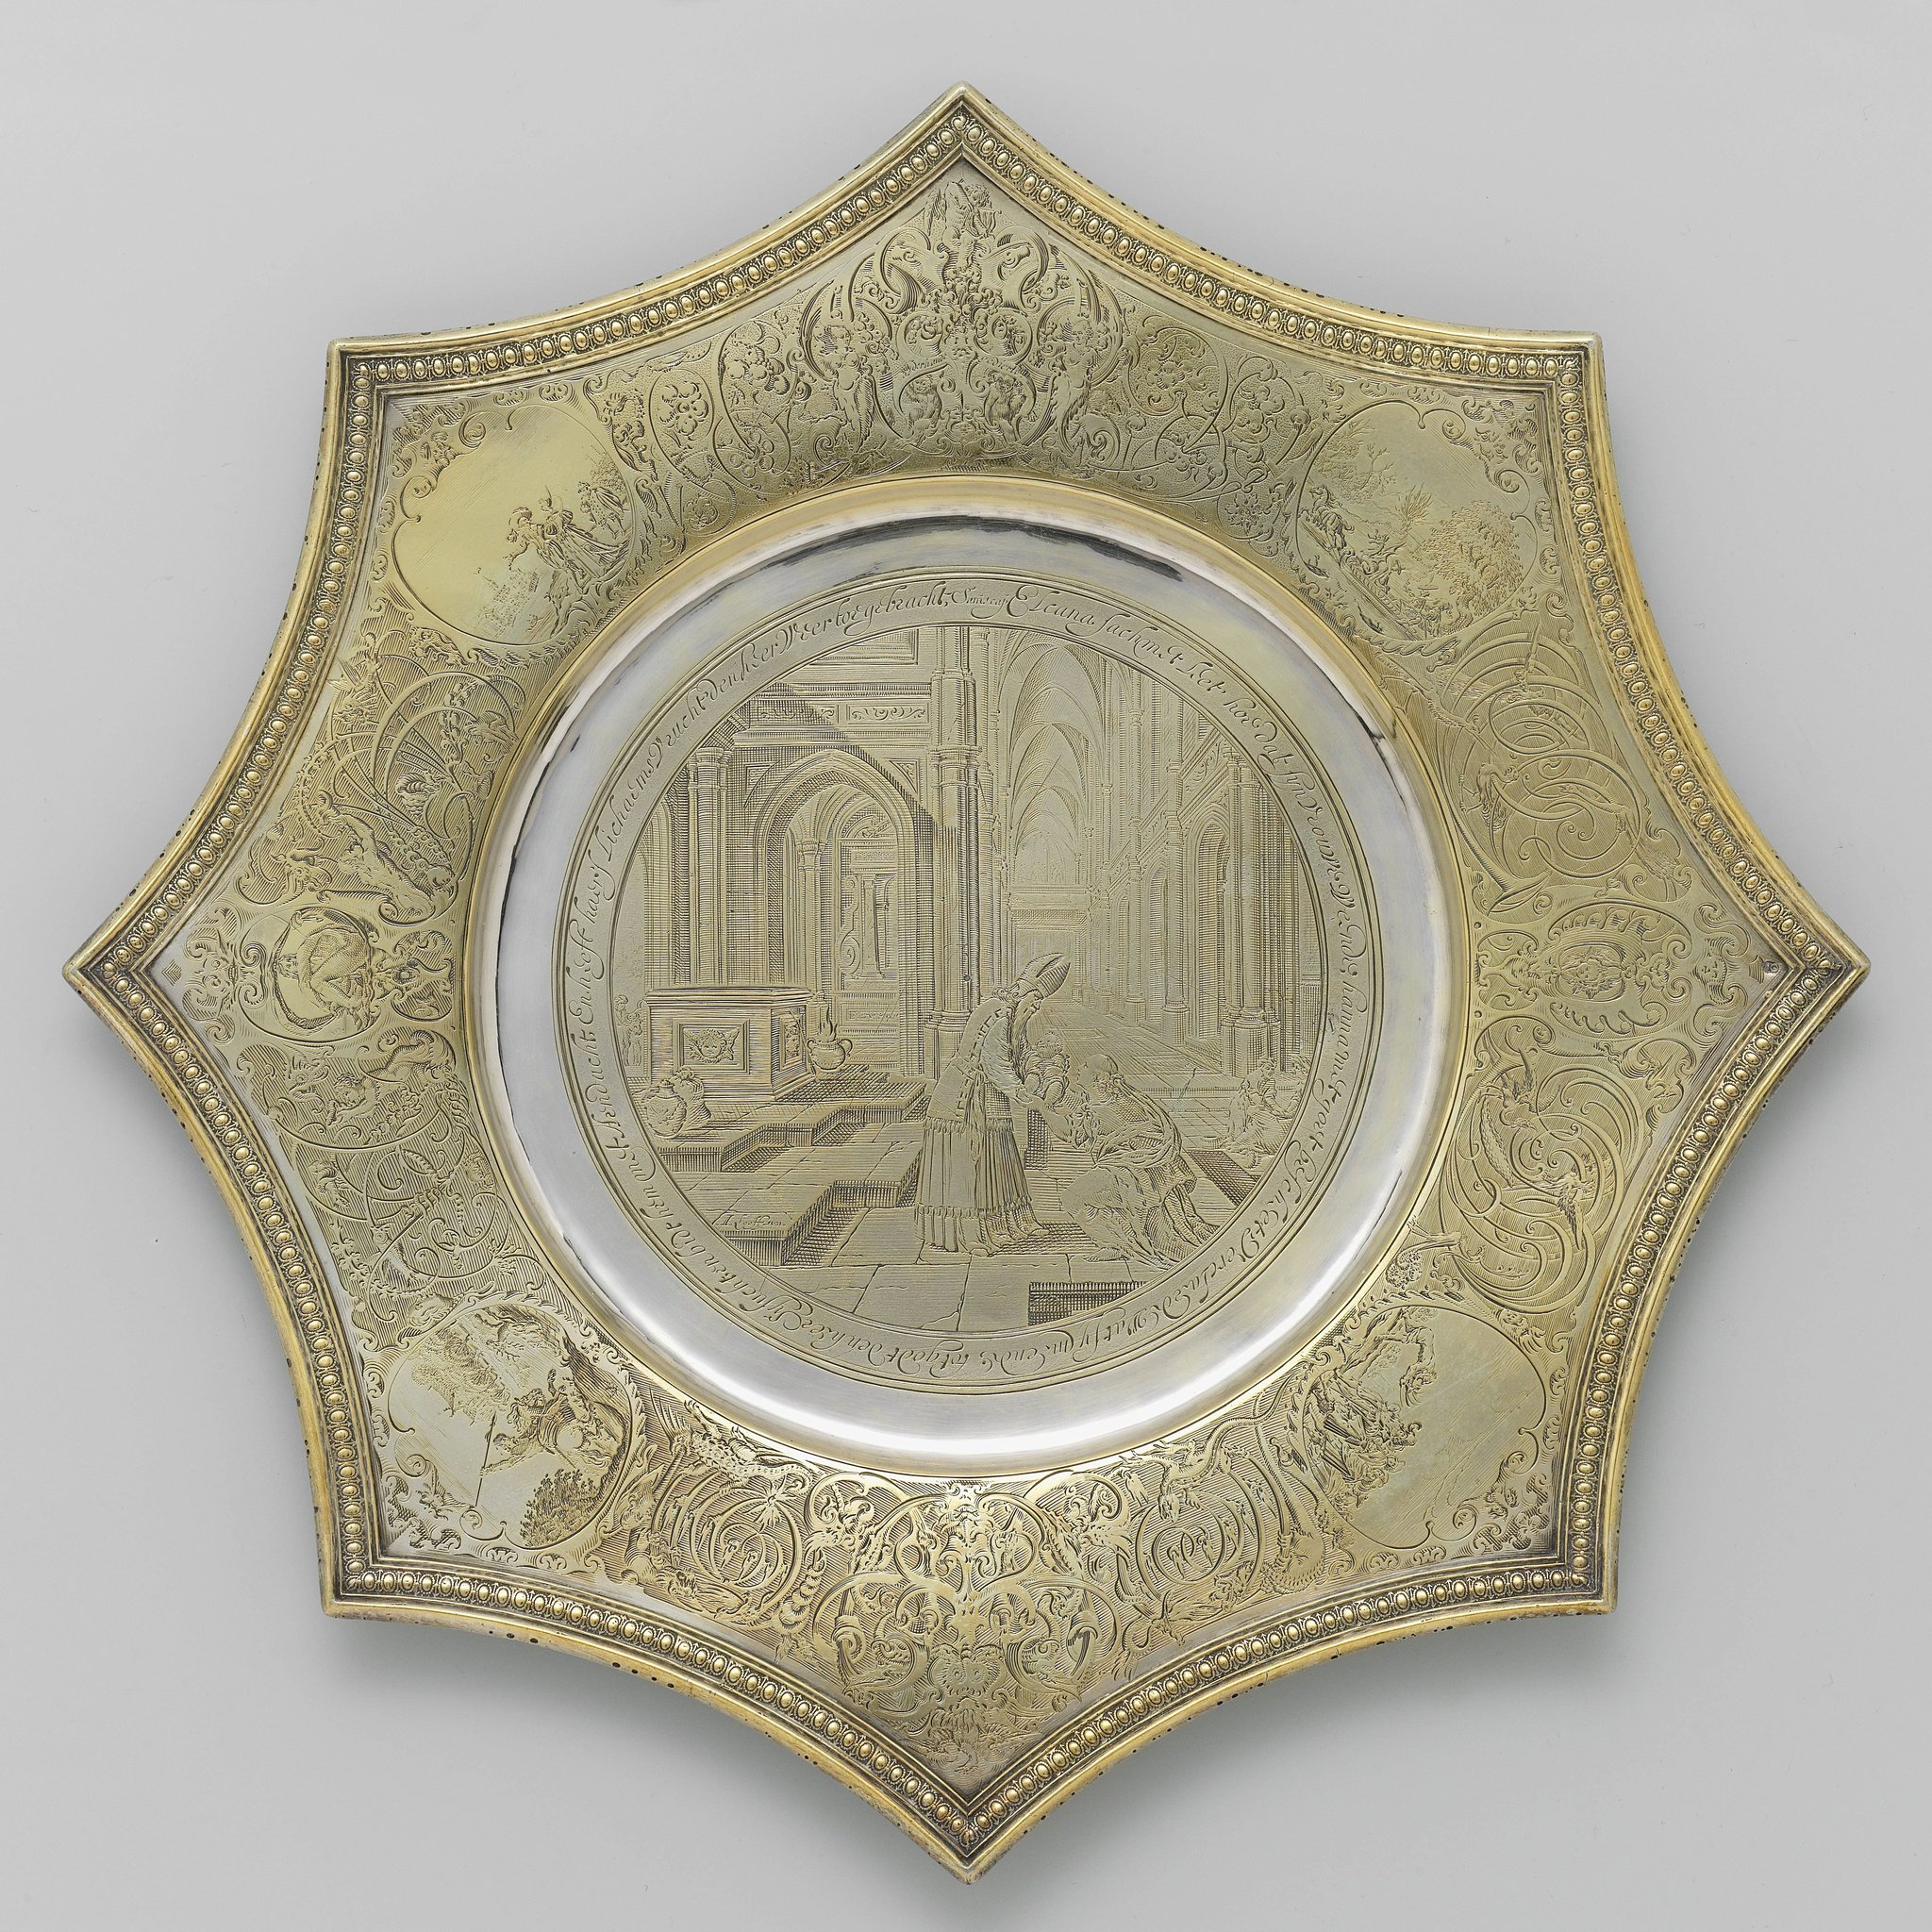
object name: dish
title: Pointed salver with Hannah and Samuel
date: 1618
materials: silver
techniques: gilding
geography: middelburg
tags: ornaments ~ art, samuel in the temple at shiloh presented to eli by hannah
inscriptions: maker's mark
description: The engraving on this salver demonstrates the sheer virtuosity of the Zeeland seal engraver Johannes Looff. With incised grooves varying in depth and width, he rendered a painting by the Zeeland painter Dirk van Delen and prints by other contemporaries in silver. Thanks to the gilding, the refined play of light can still be admired in its full glory.